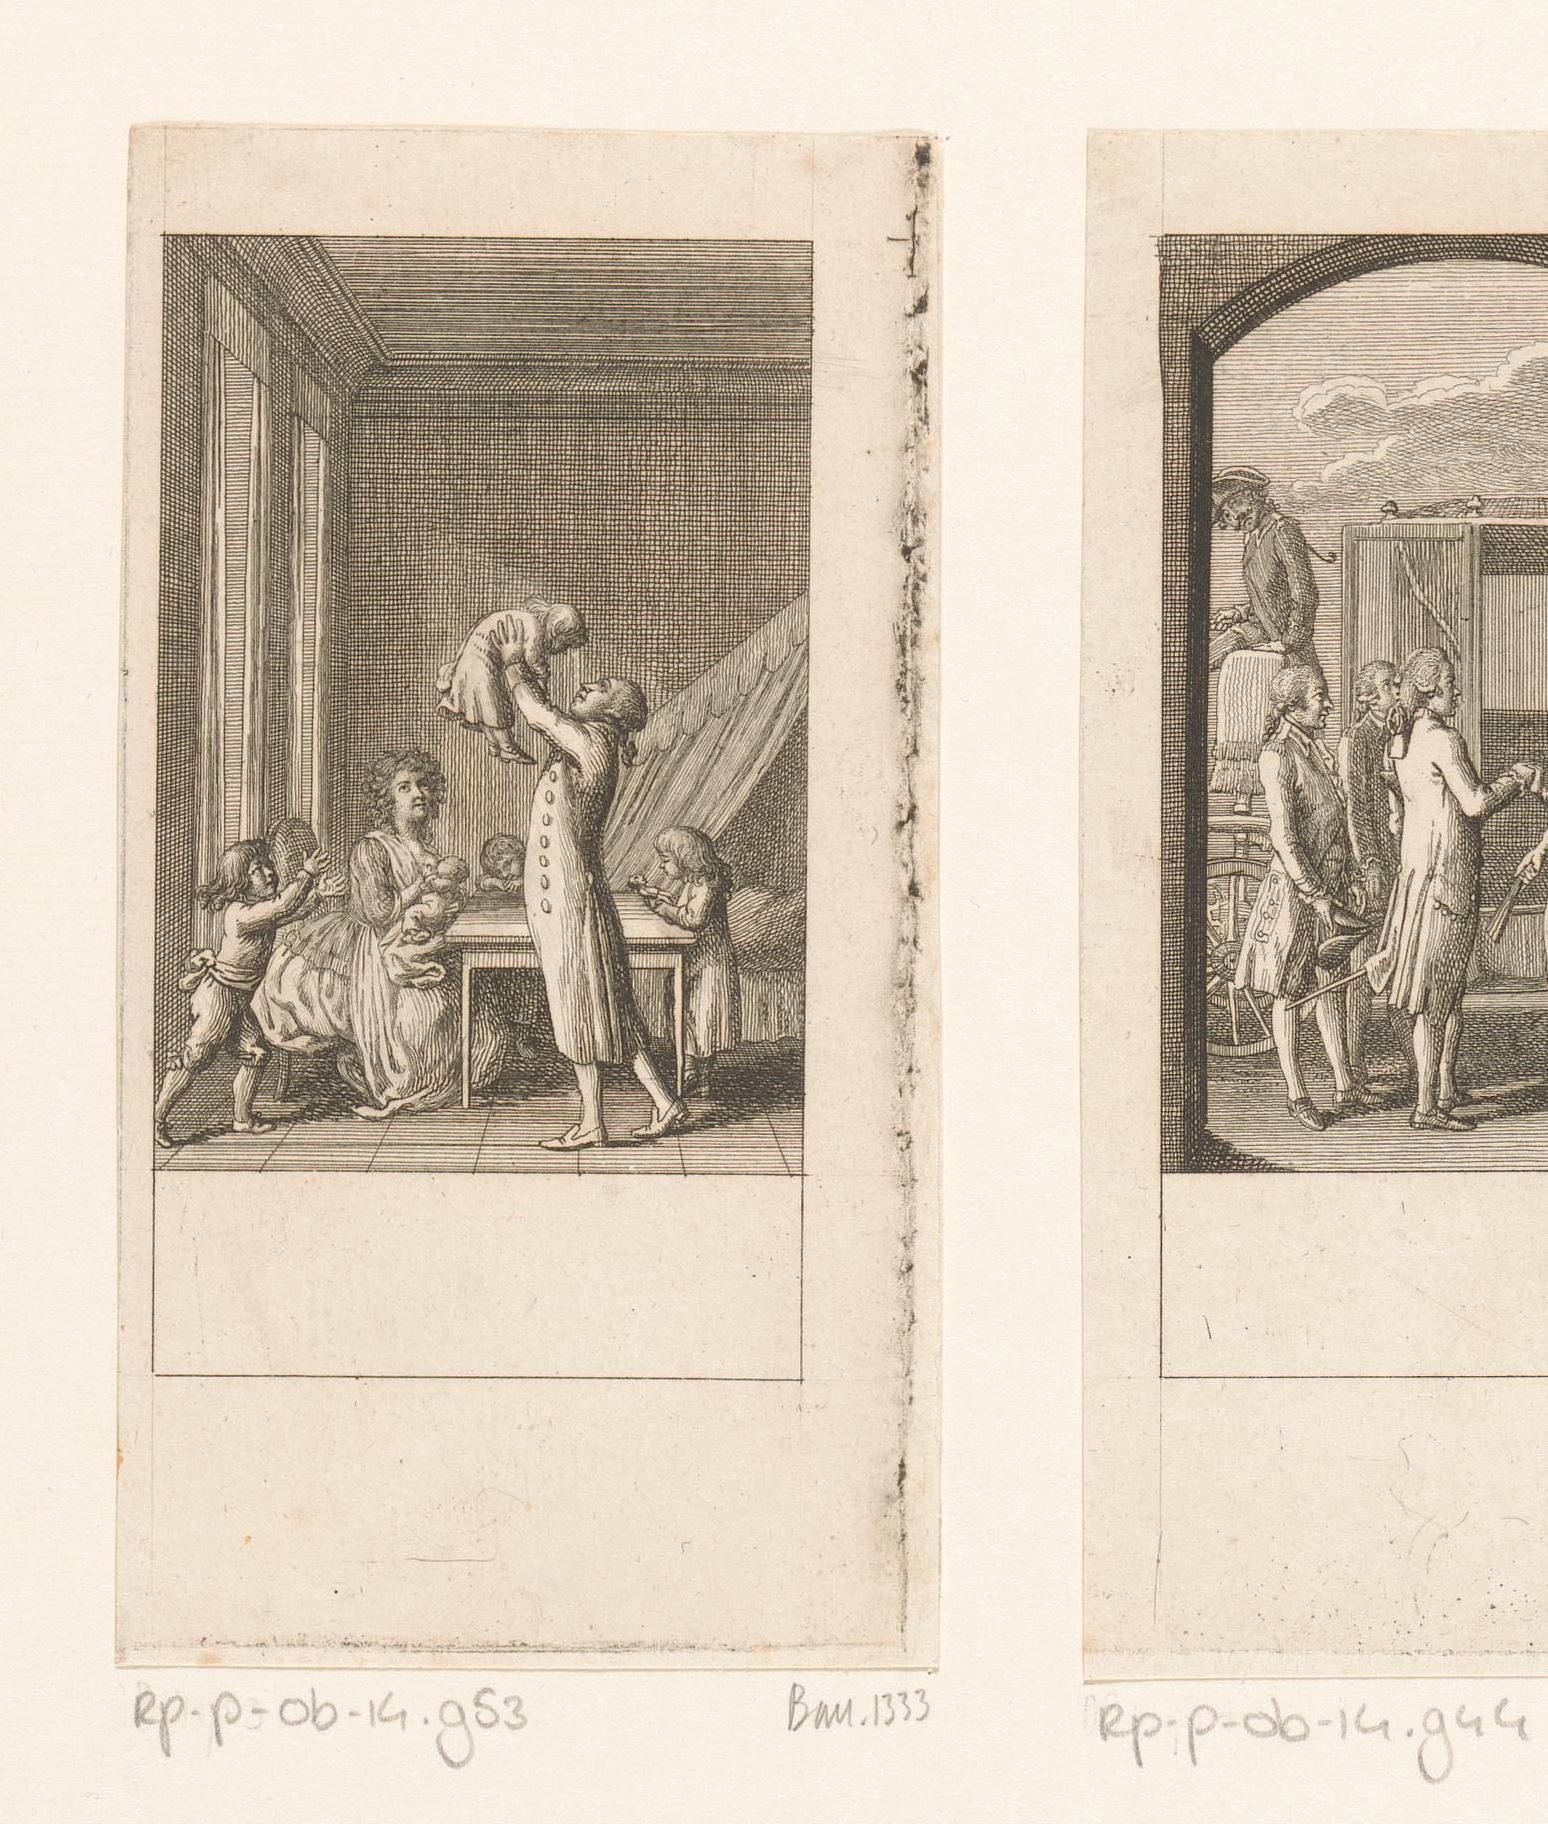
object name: print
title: Huiselijk geluk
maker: daniel nikolaus chodowiecki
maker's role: draughtsman, print maker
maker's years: 1726-1801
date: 1788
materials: paper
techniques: etching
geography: berlin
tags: parents with their children, betrothal and marriage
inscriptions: collector's mark: Lugt 2228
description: Latere staat gebruikt voor: Goettinger Taschen Calender vom Jahr 1789. [Göttingen]: Johann Christoph Dietrich, [1788].